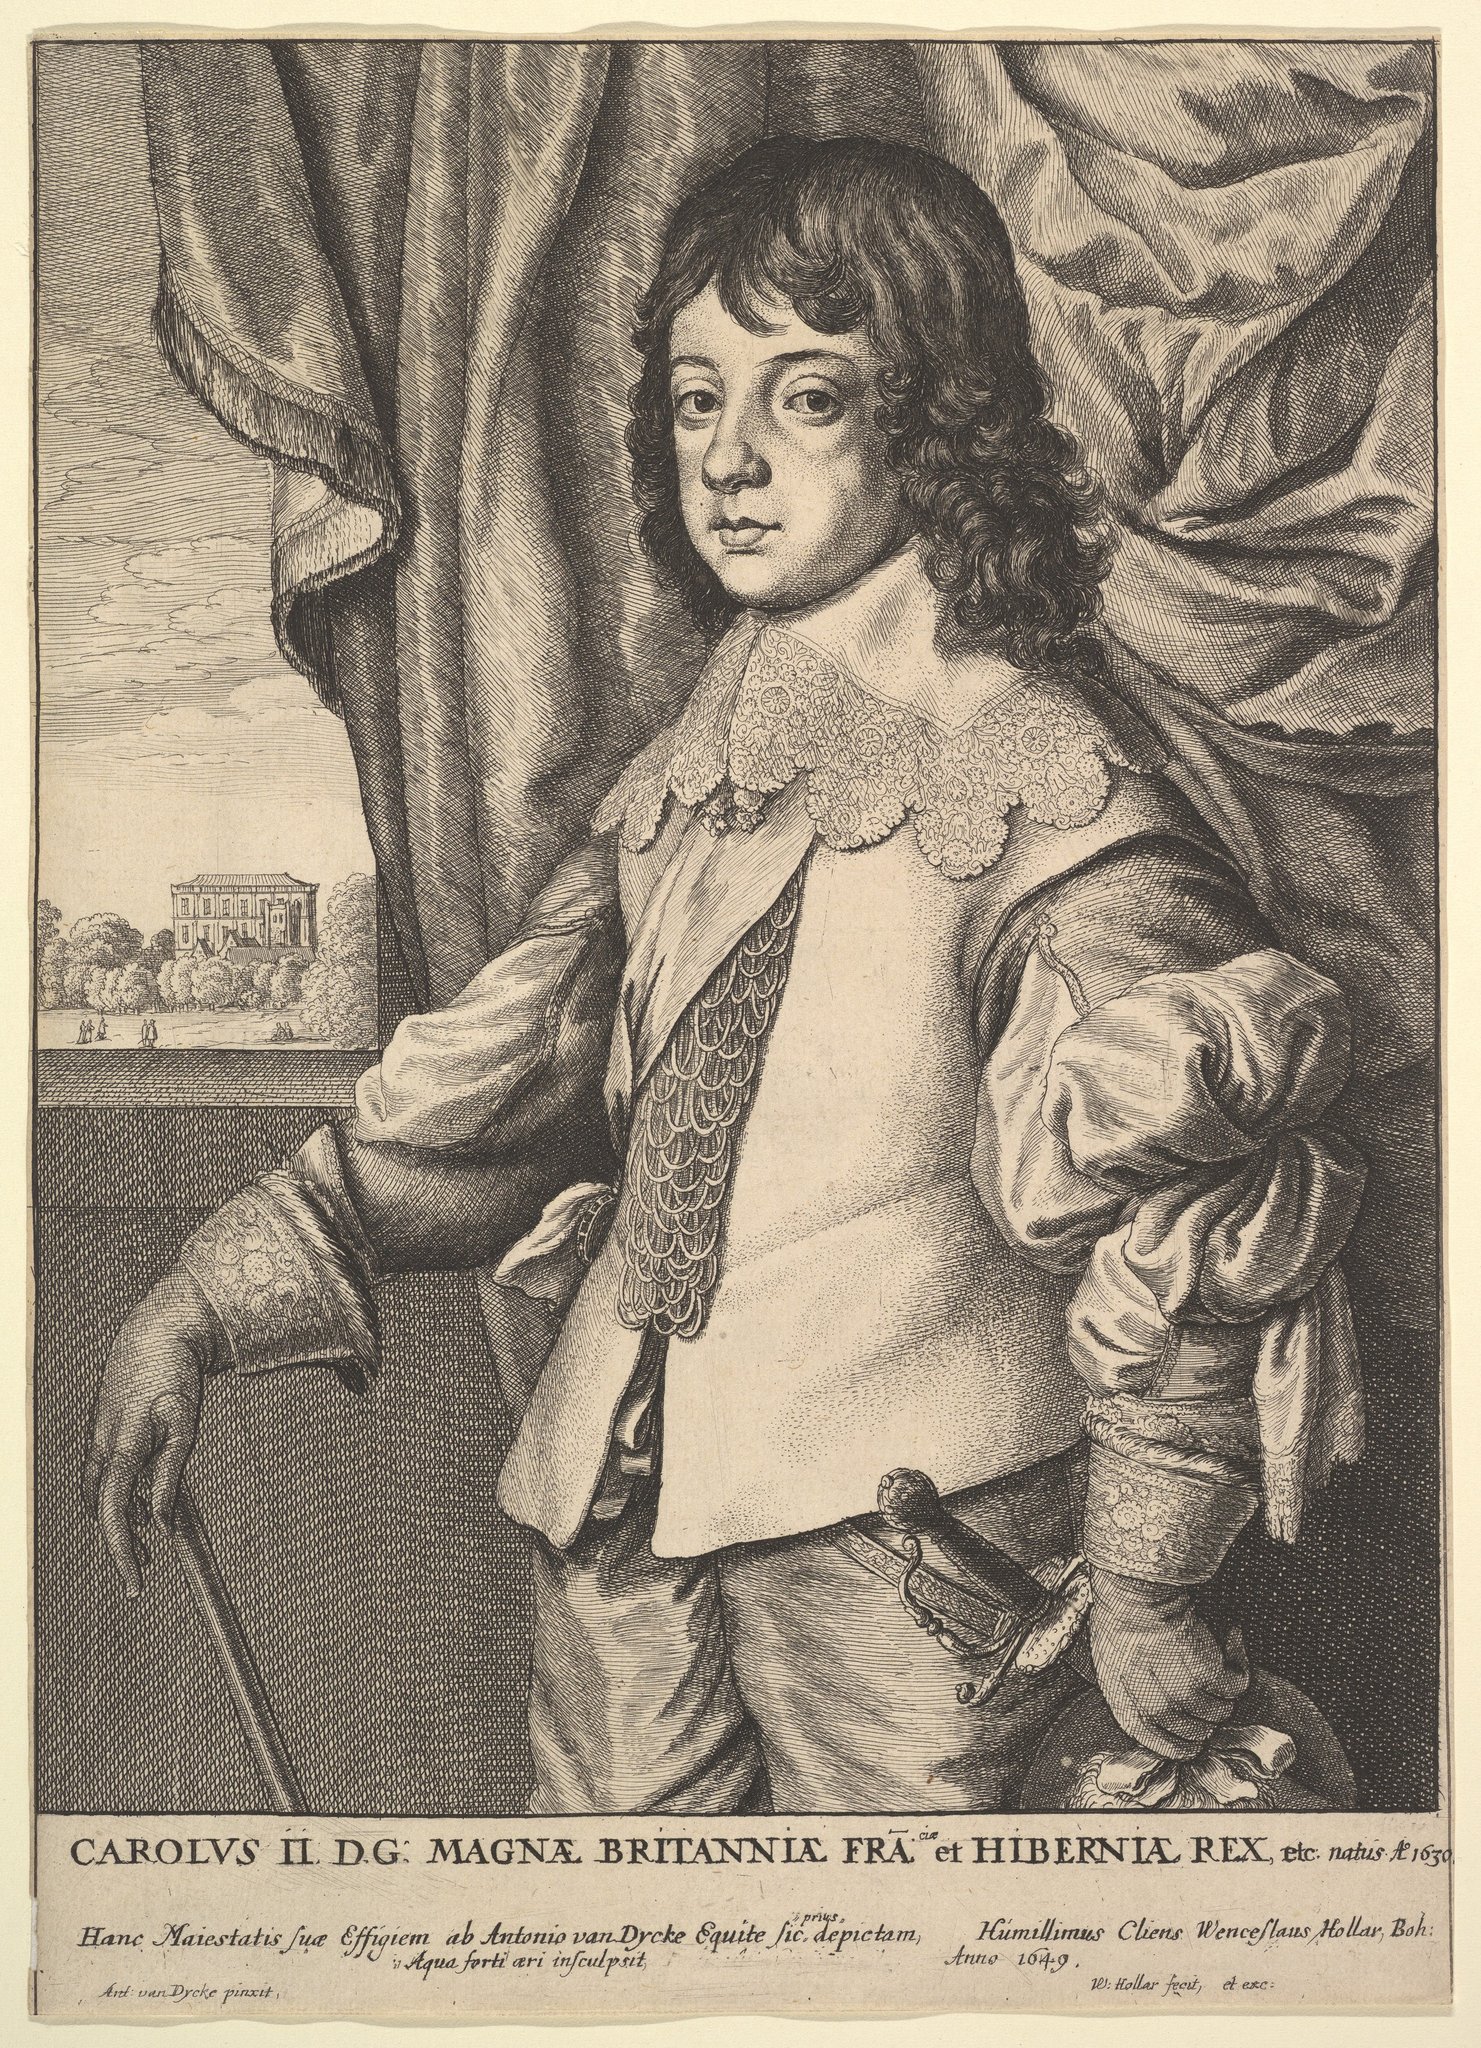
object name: print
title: Charles II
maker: wenceslaus hollar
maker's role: artist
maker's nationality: bohemian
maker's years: 1607-1677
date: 1649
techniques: etching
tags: kings,boys,portraits,charles ii